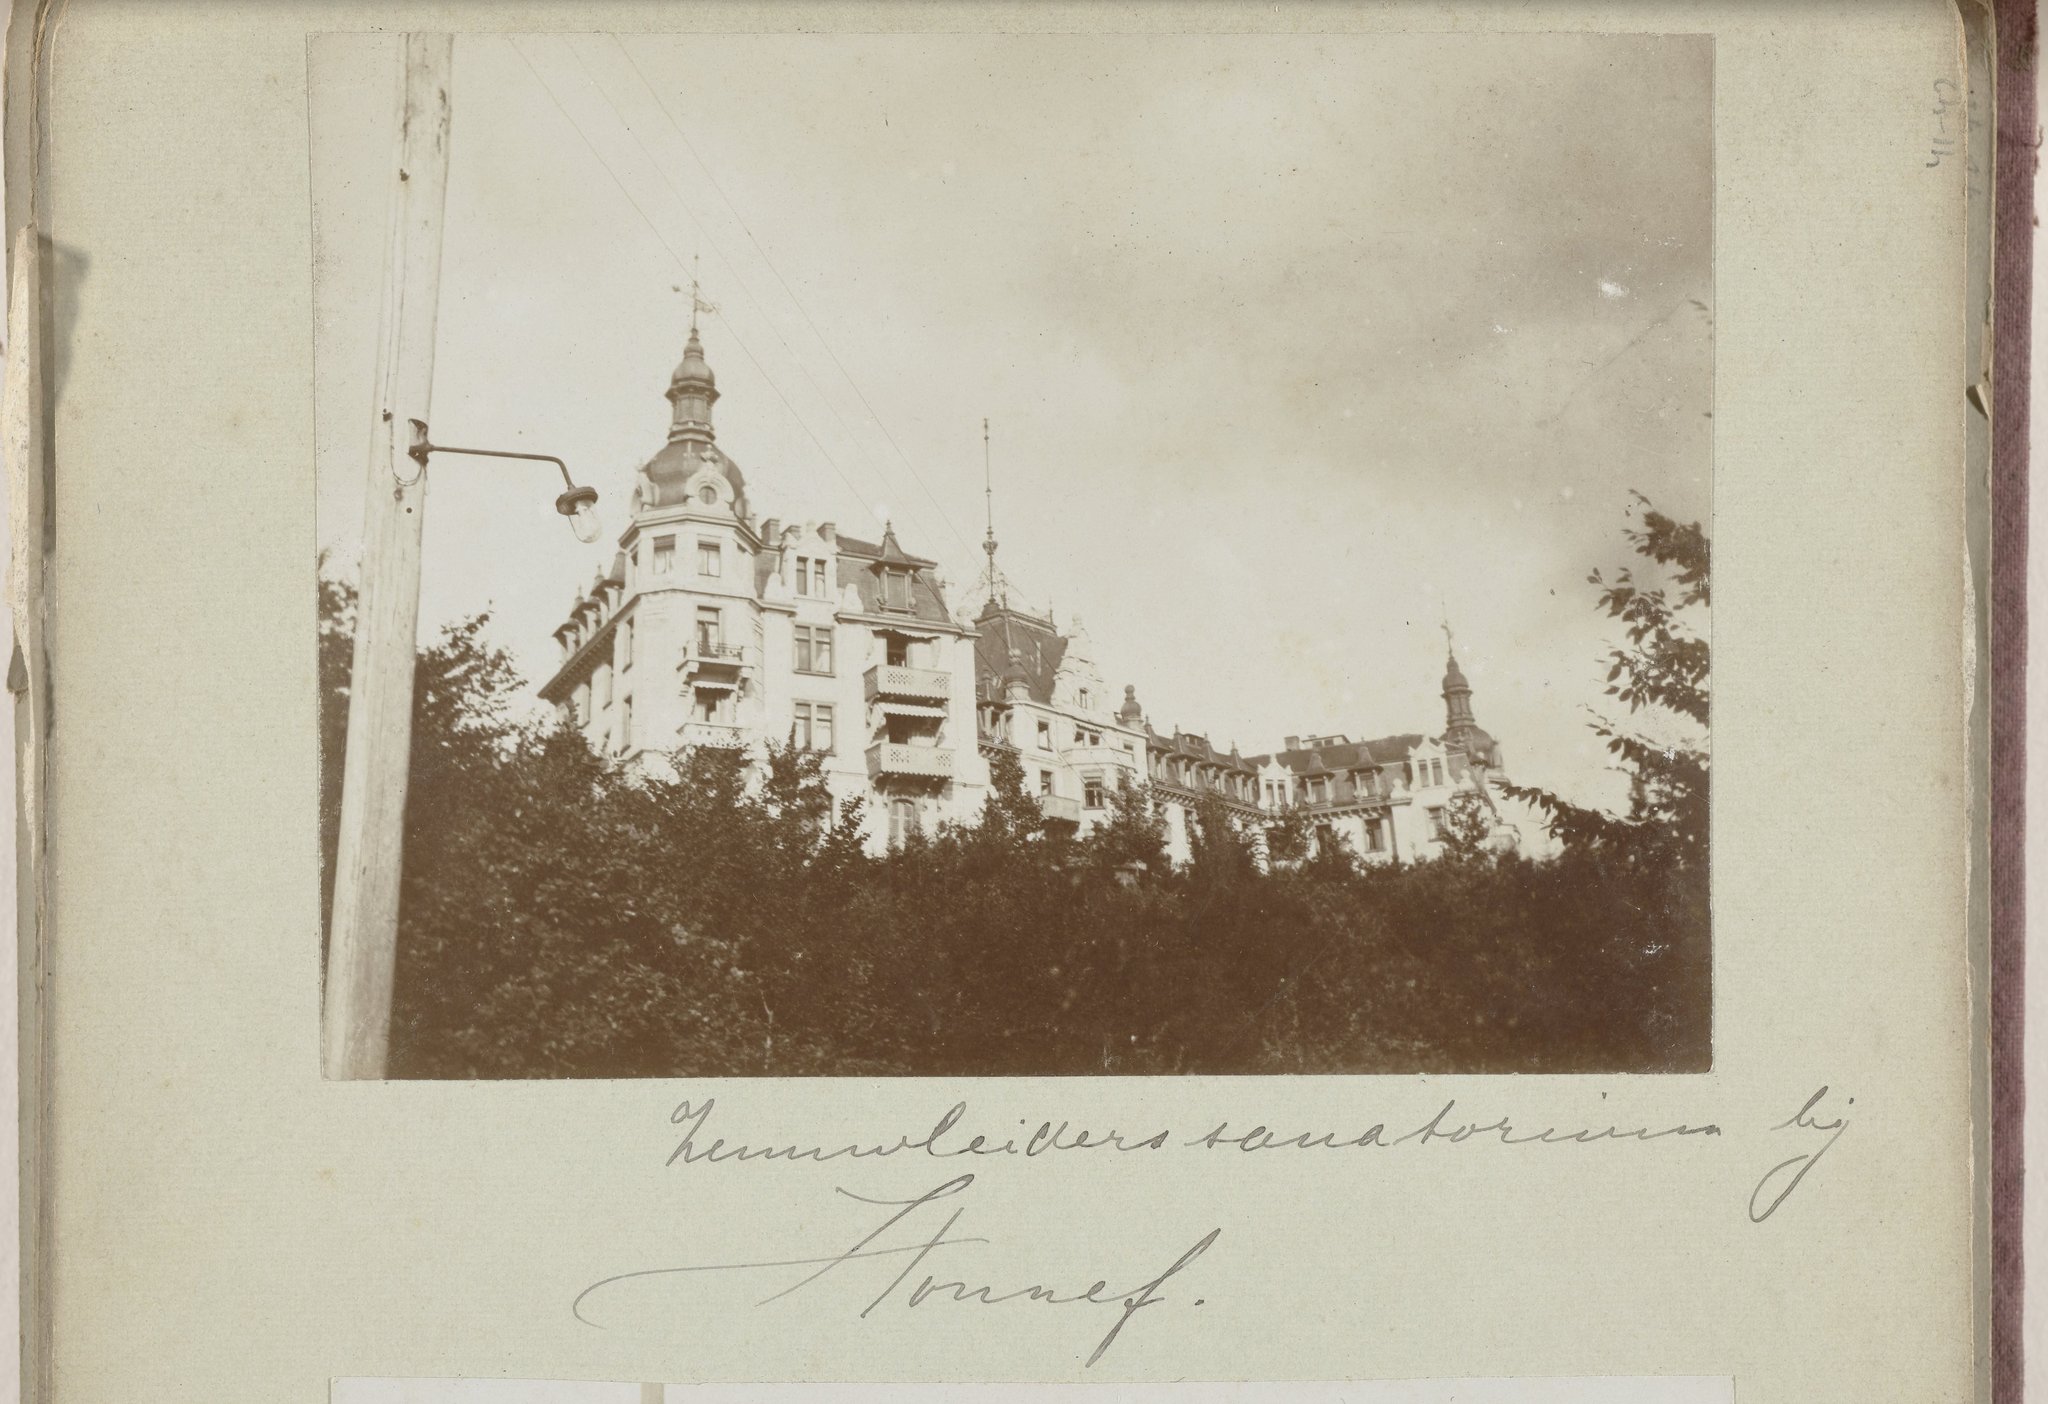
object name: album leaf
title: Sanatorium bij Bad Honnef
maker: david vermeulen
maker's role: fotograaf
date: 1895-1905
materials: paper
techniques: collodion silver print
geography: bad honnef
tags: specialized institutions